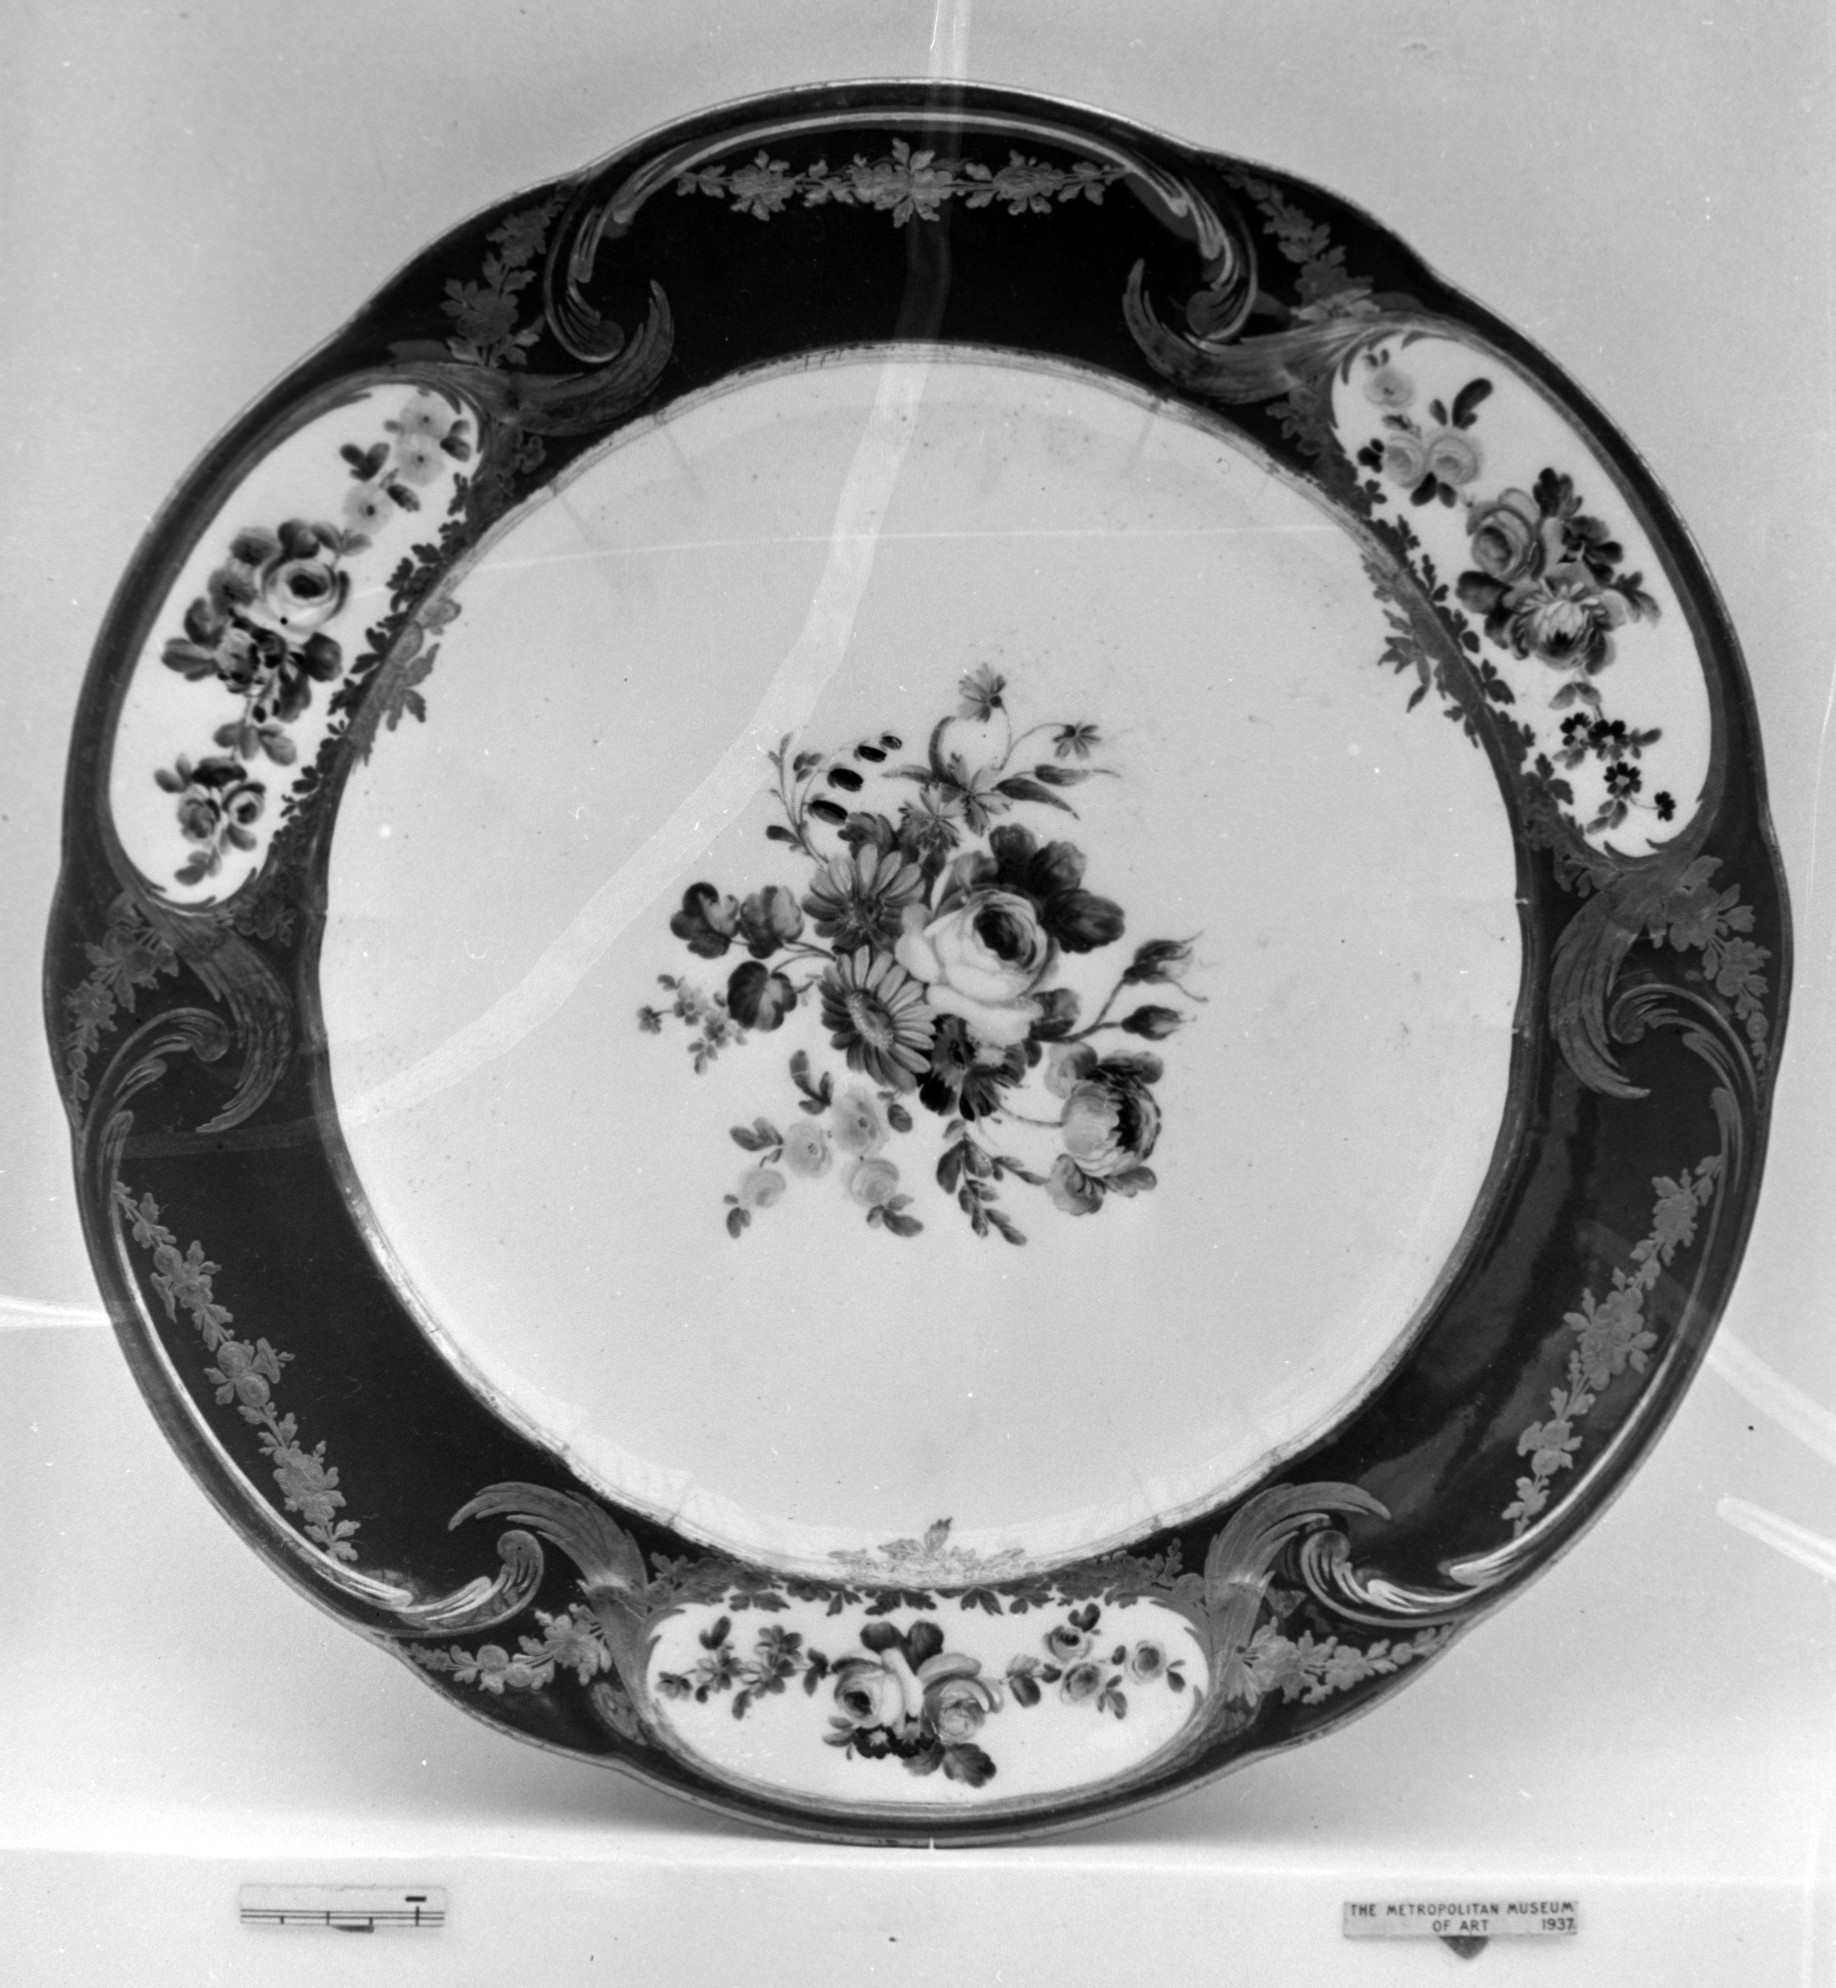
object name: plate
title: Plate (Assiette à palmes) (1 of 102) (part of a service)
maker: sèvres manufactory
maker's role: manufactory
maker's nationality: french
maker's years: 1740-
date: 1786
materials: soft paste porcelain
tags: roses